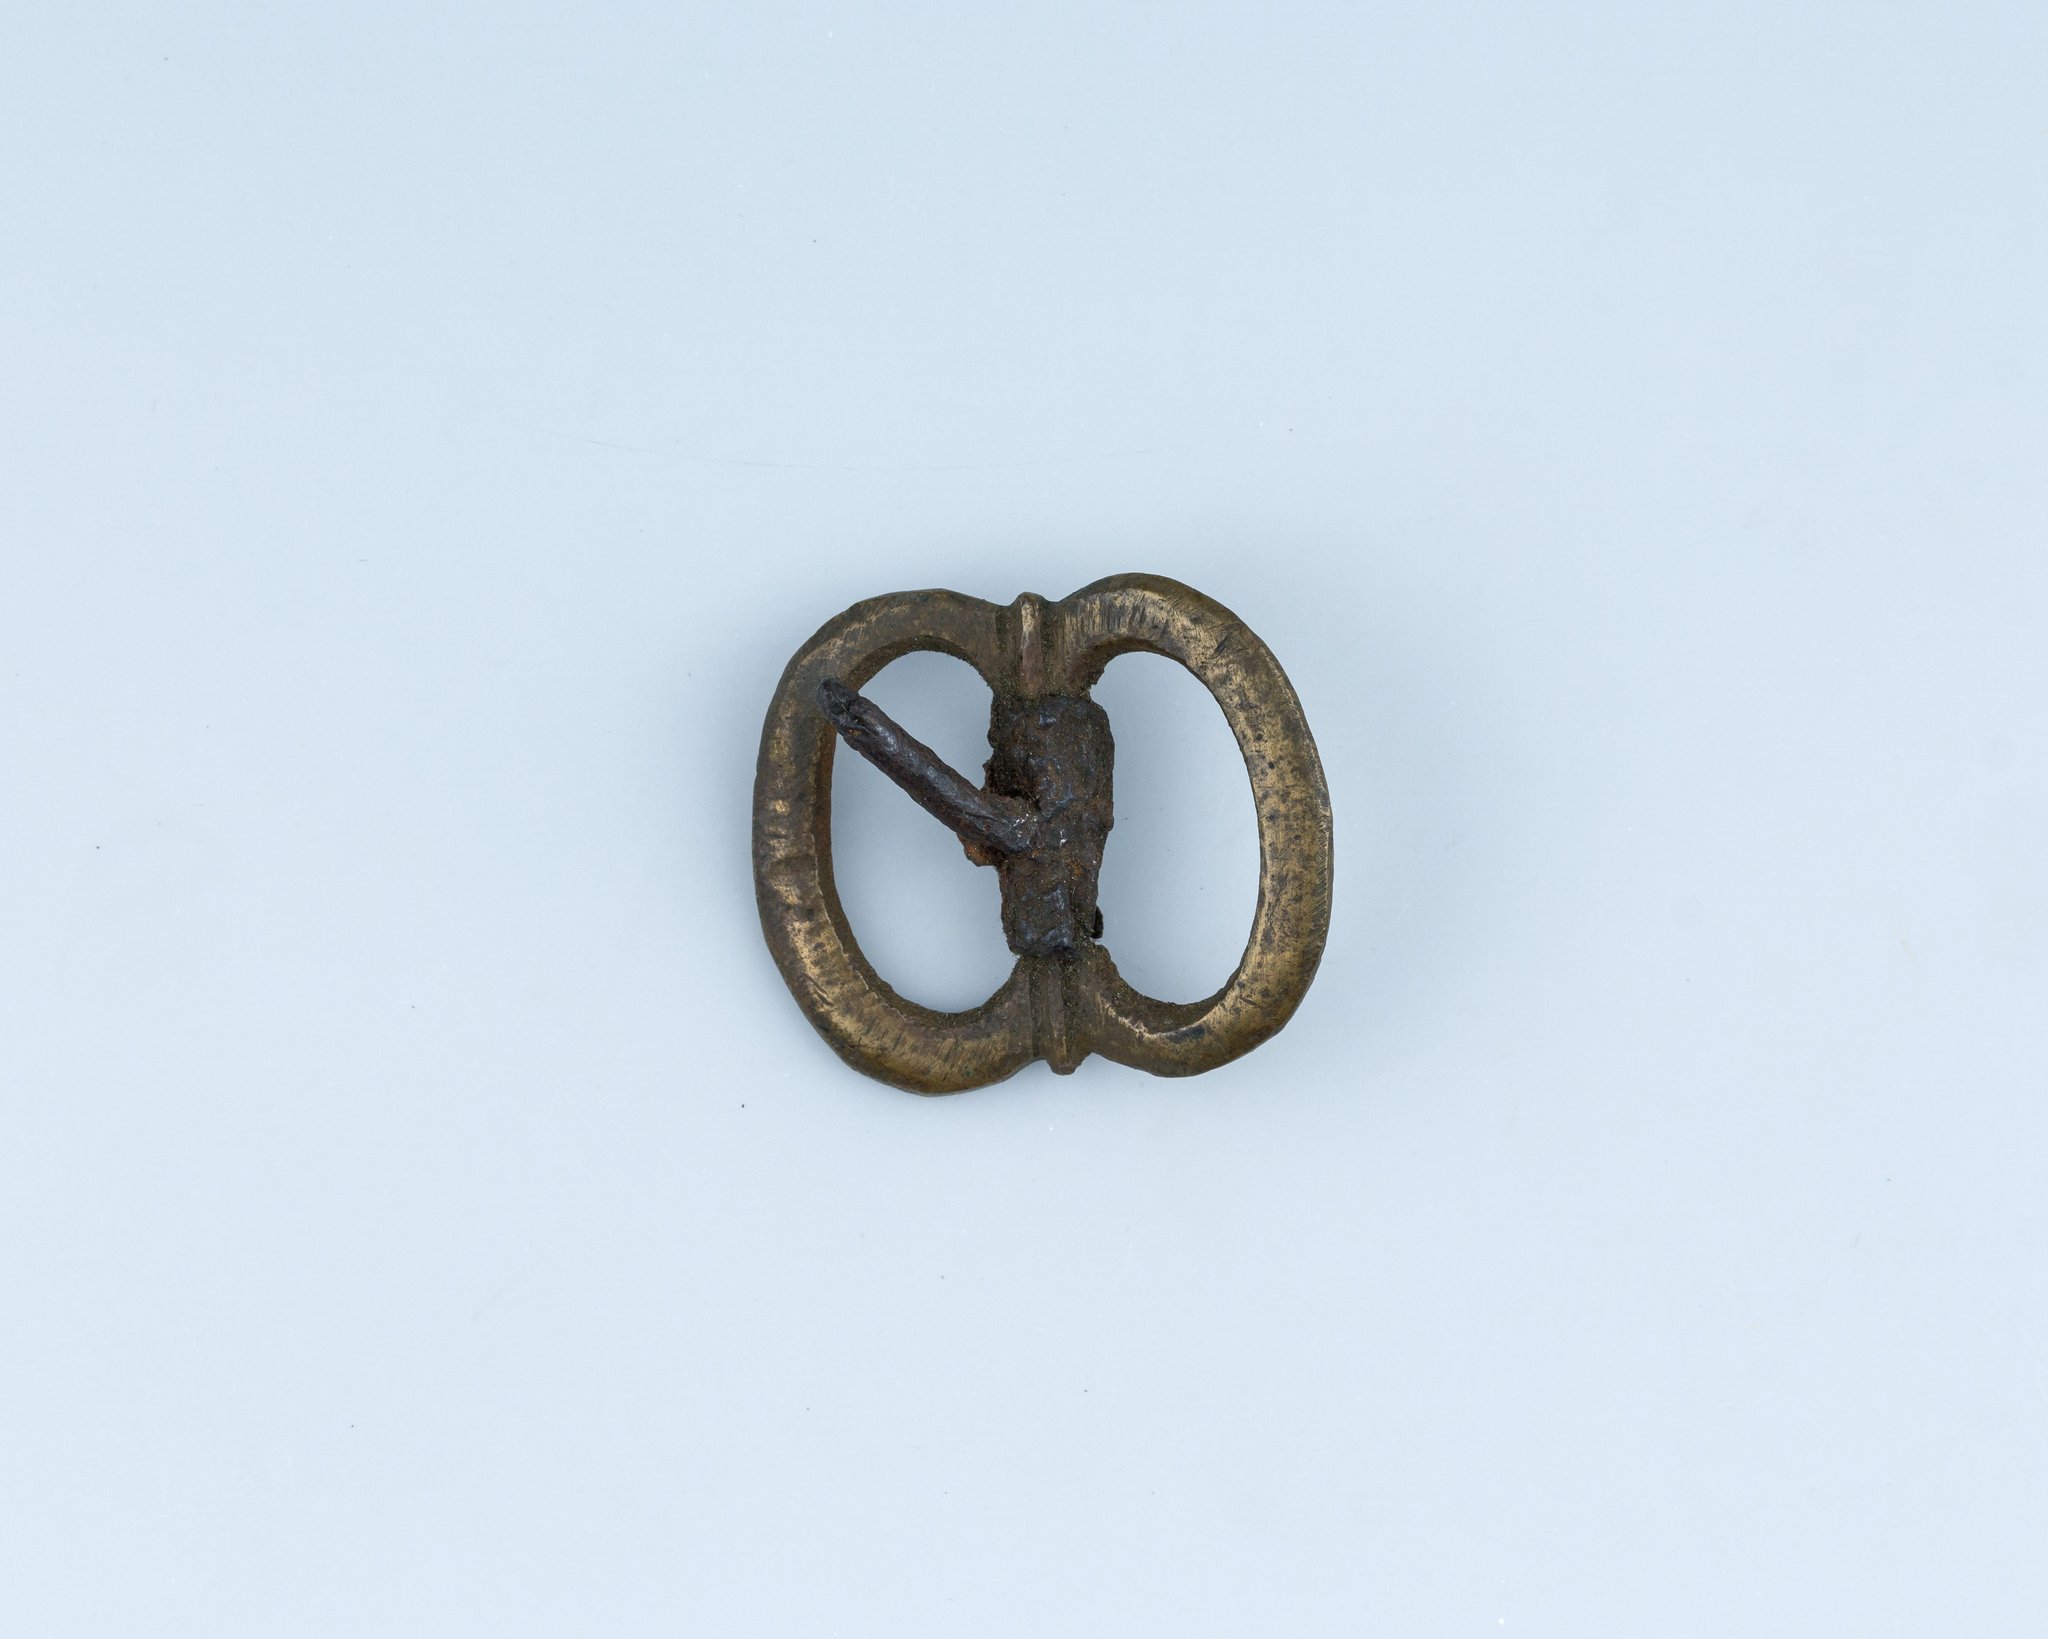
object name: buckle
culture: european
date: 1401-1700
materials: brass, steel